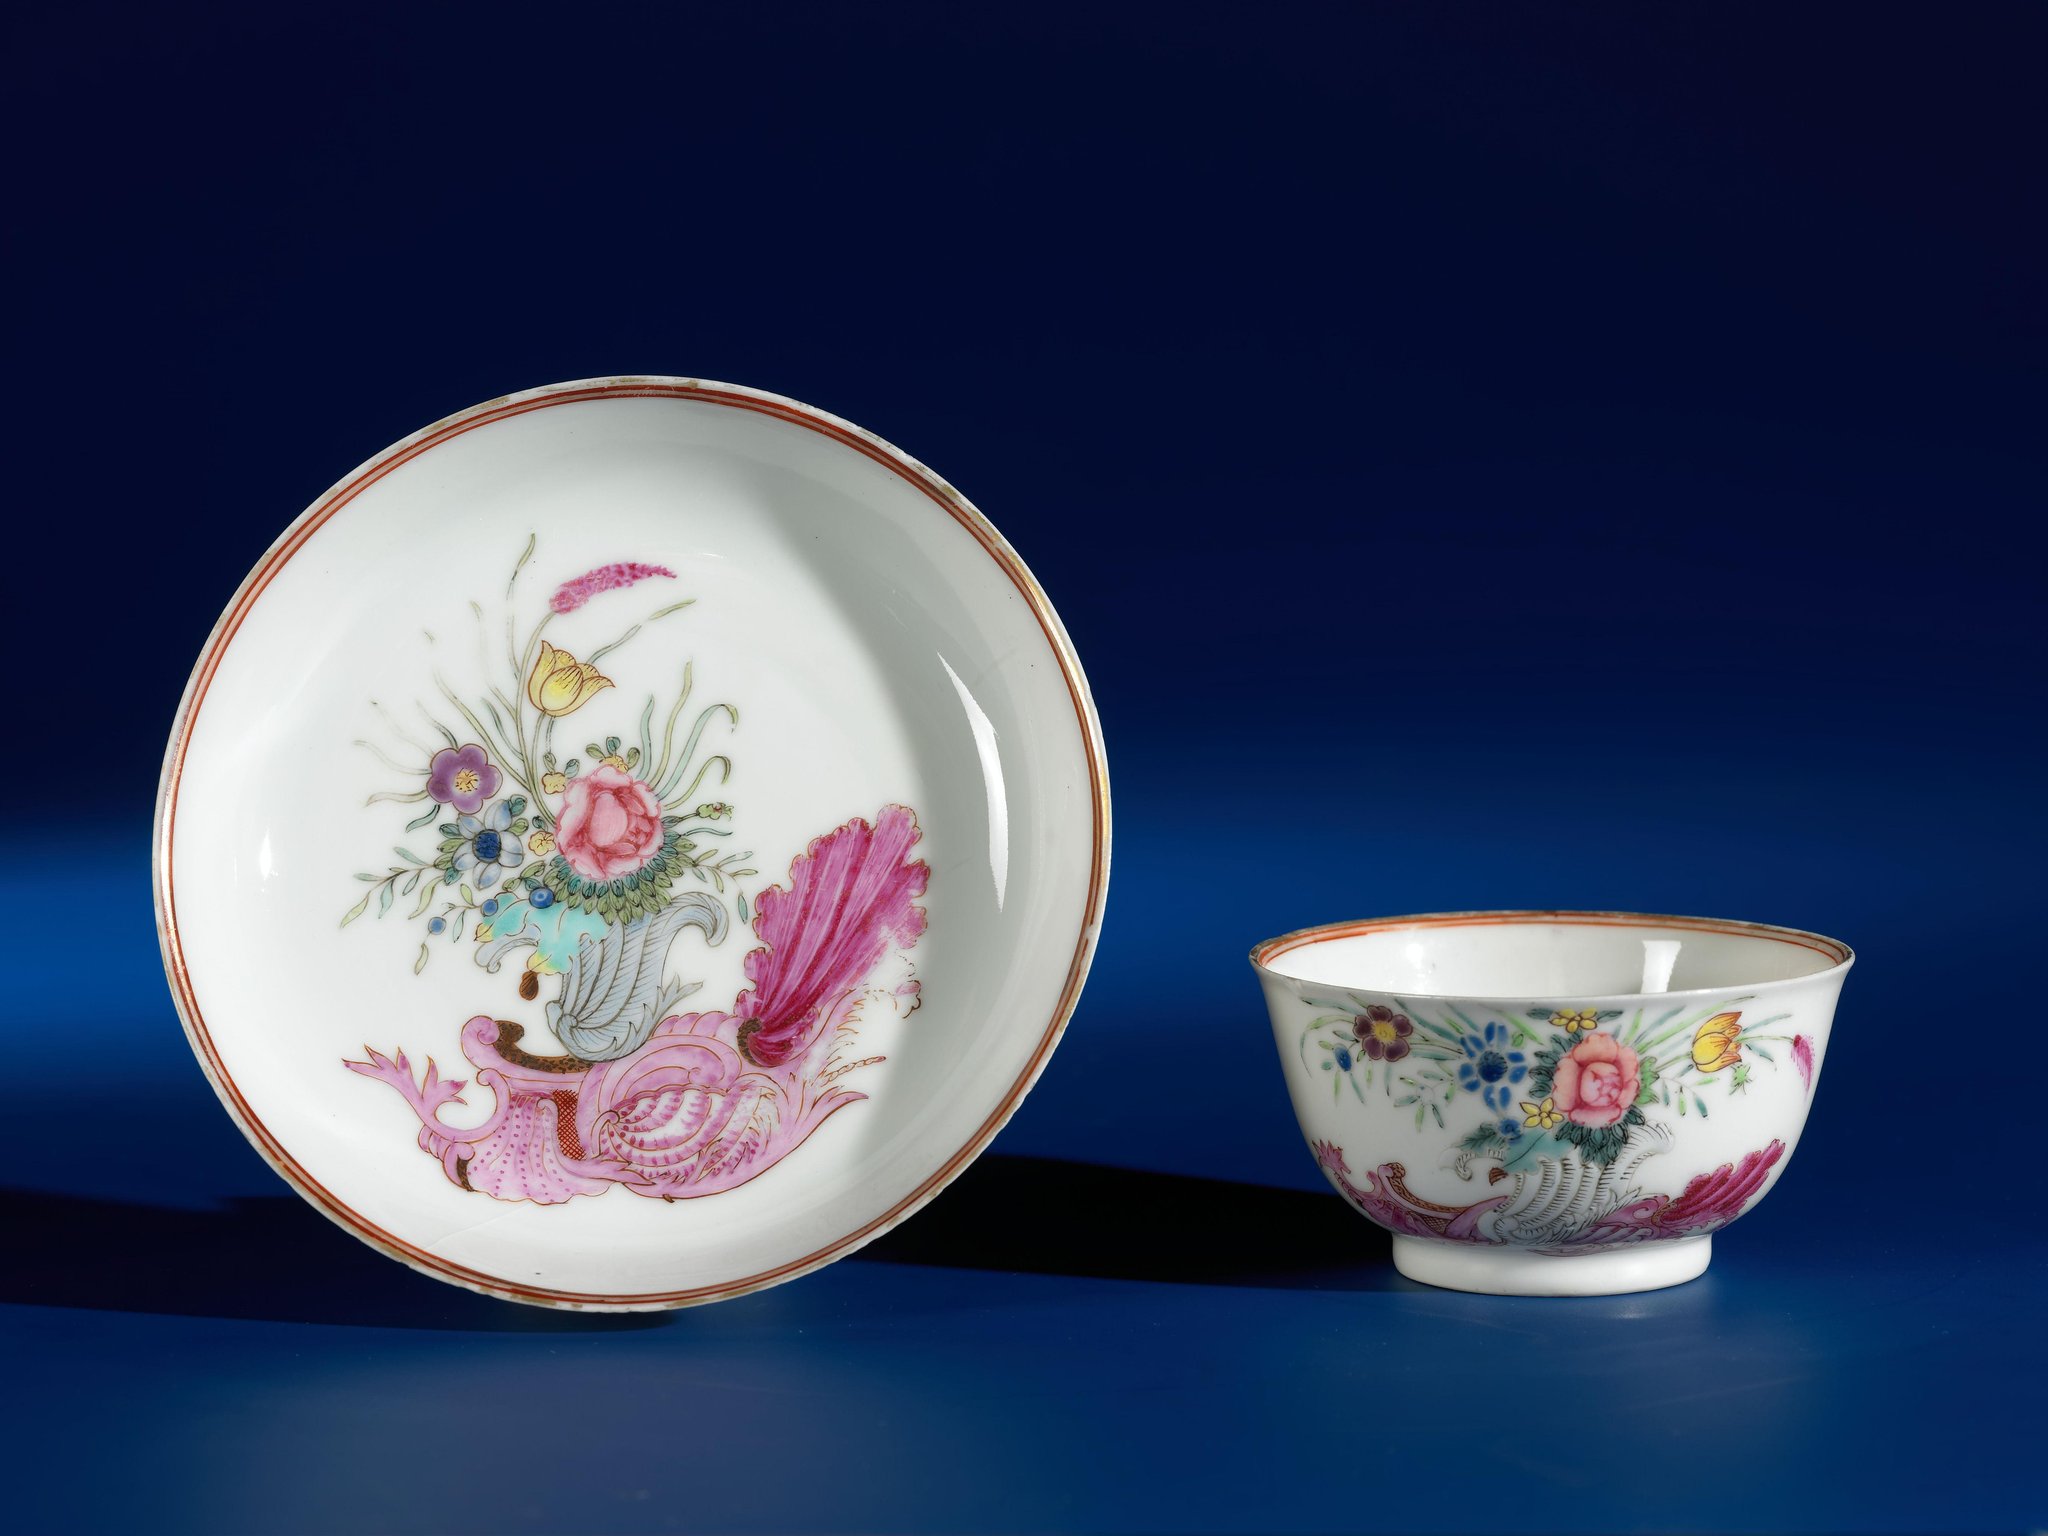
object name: cup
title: Bell-shaped cup with a snailornament and flowering plants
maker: Anonymous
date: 1750-1774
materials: glaze, gold, paint, porcelain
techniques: firing, gilding, turning, vitrification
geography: china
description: Klokvormige kop van porselein, beschilderd op het glazuur in blauw, rood, roze, groen, geel, zwart en goud. Op de wand een Europees schelpornament met daarop een schelpvormige vaas met bloeiende planten; met een bloemtak. Europese voorstelling in emailkleuren.